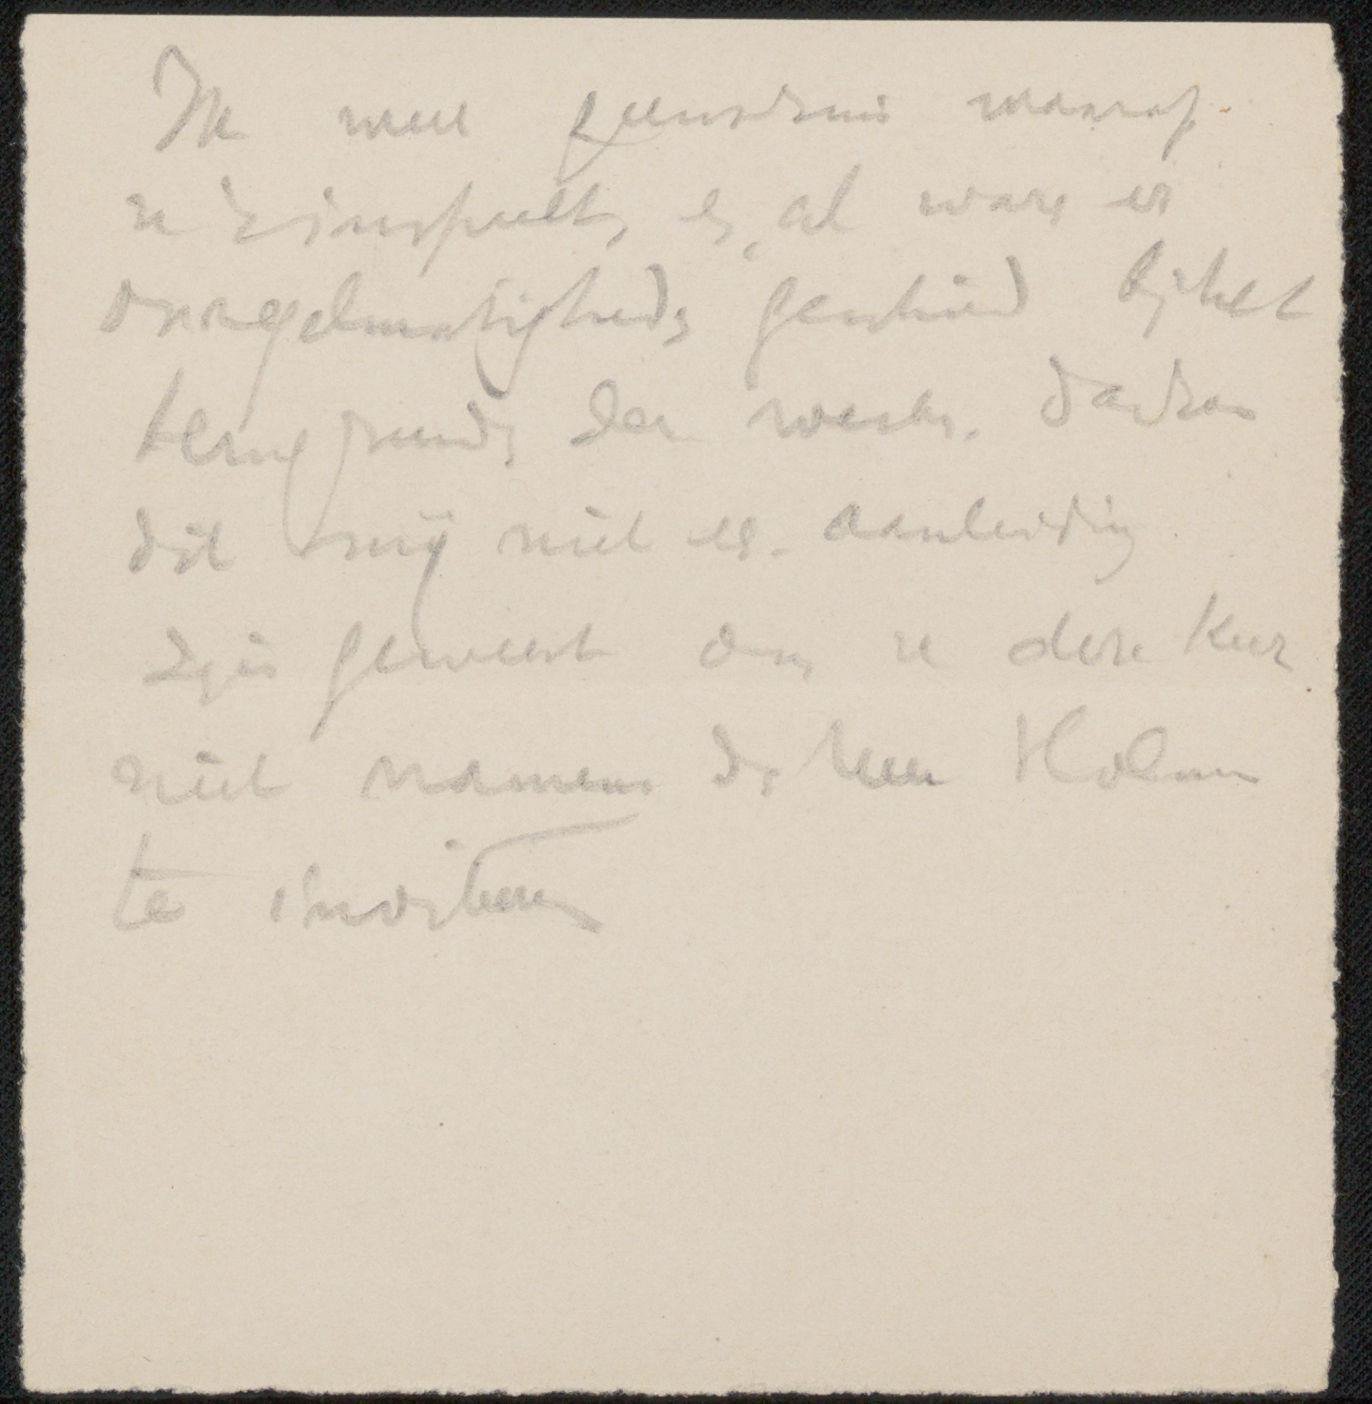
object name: aantekening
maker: philip zilcken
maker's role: draughtsman, painter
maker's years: 1857-1930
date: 1867-1930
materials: paper, pencil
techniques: writing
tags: charles holme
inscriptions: collector's mark: ‘RPK’